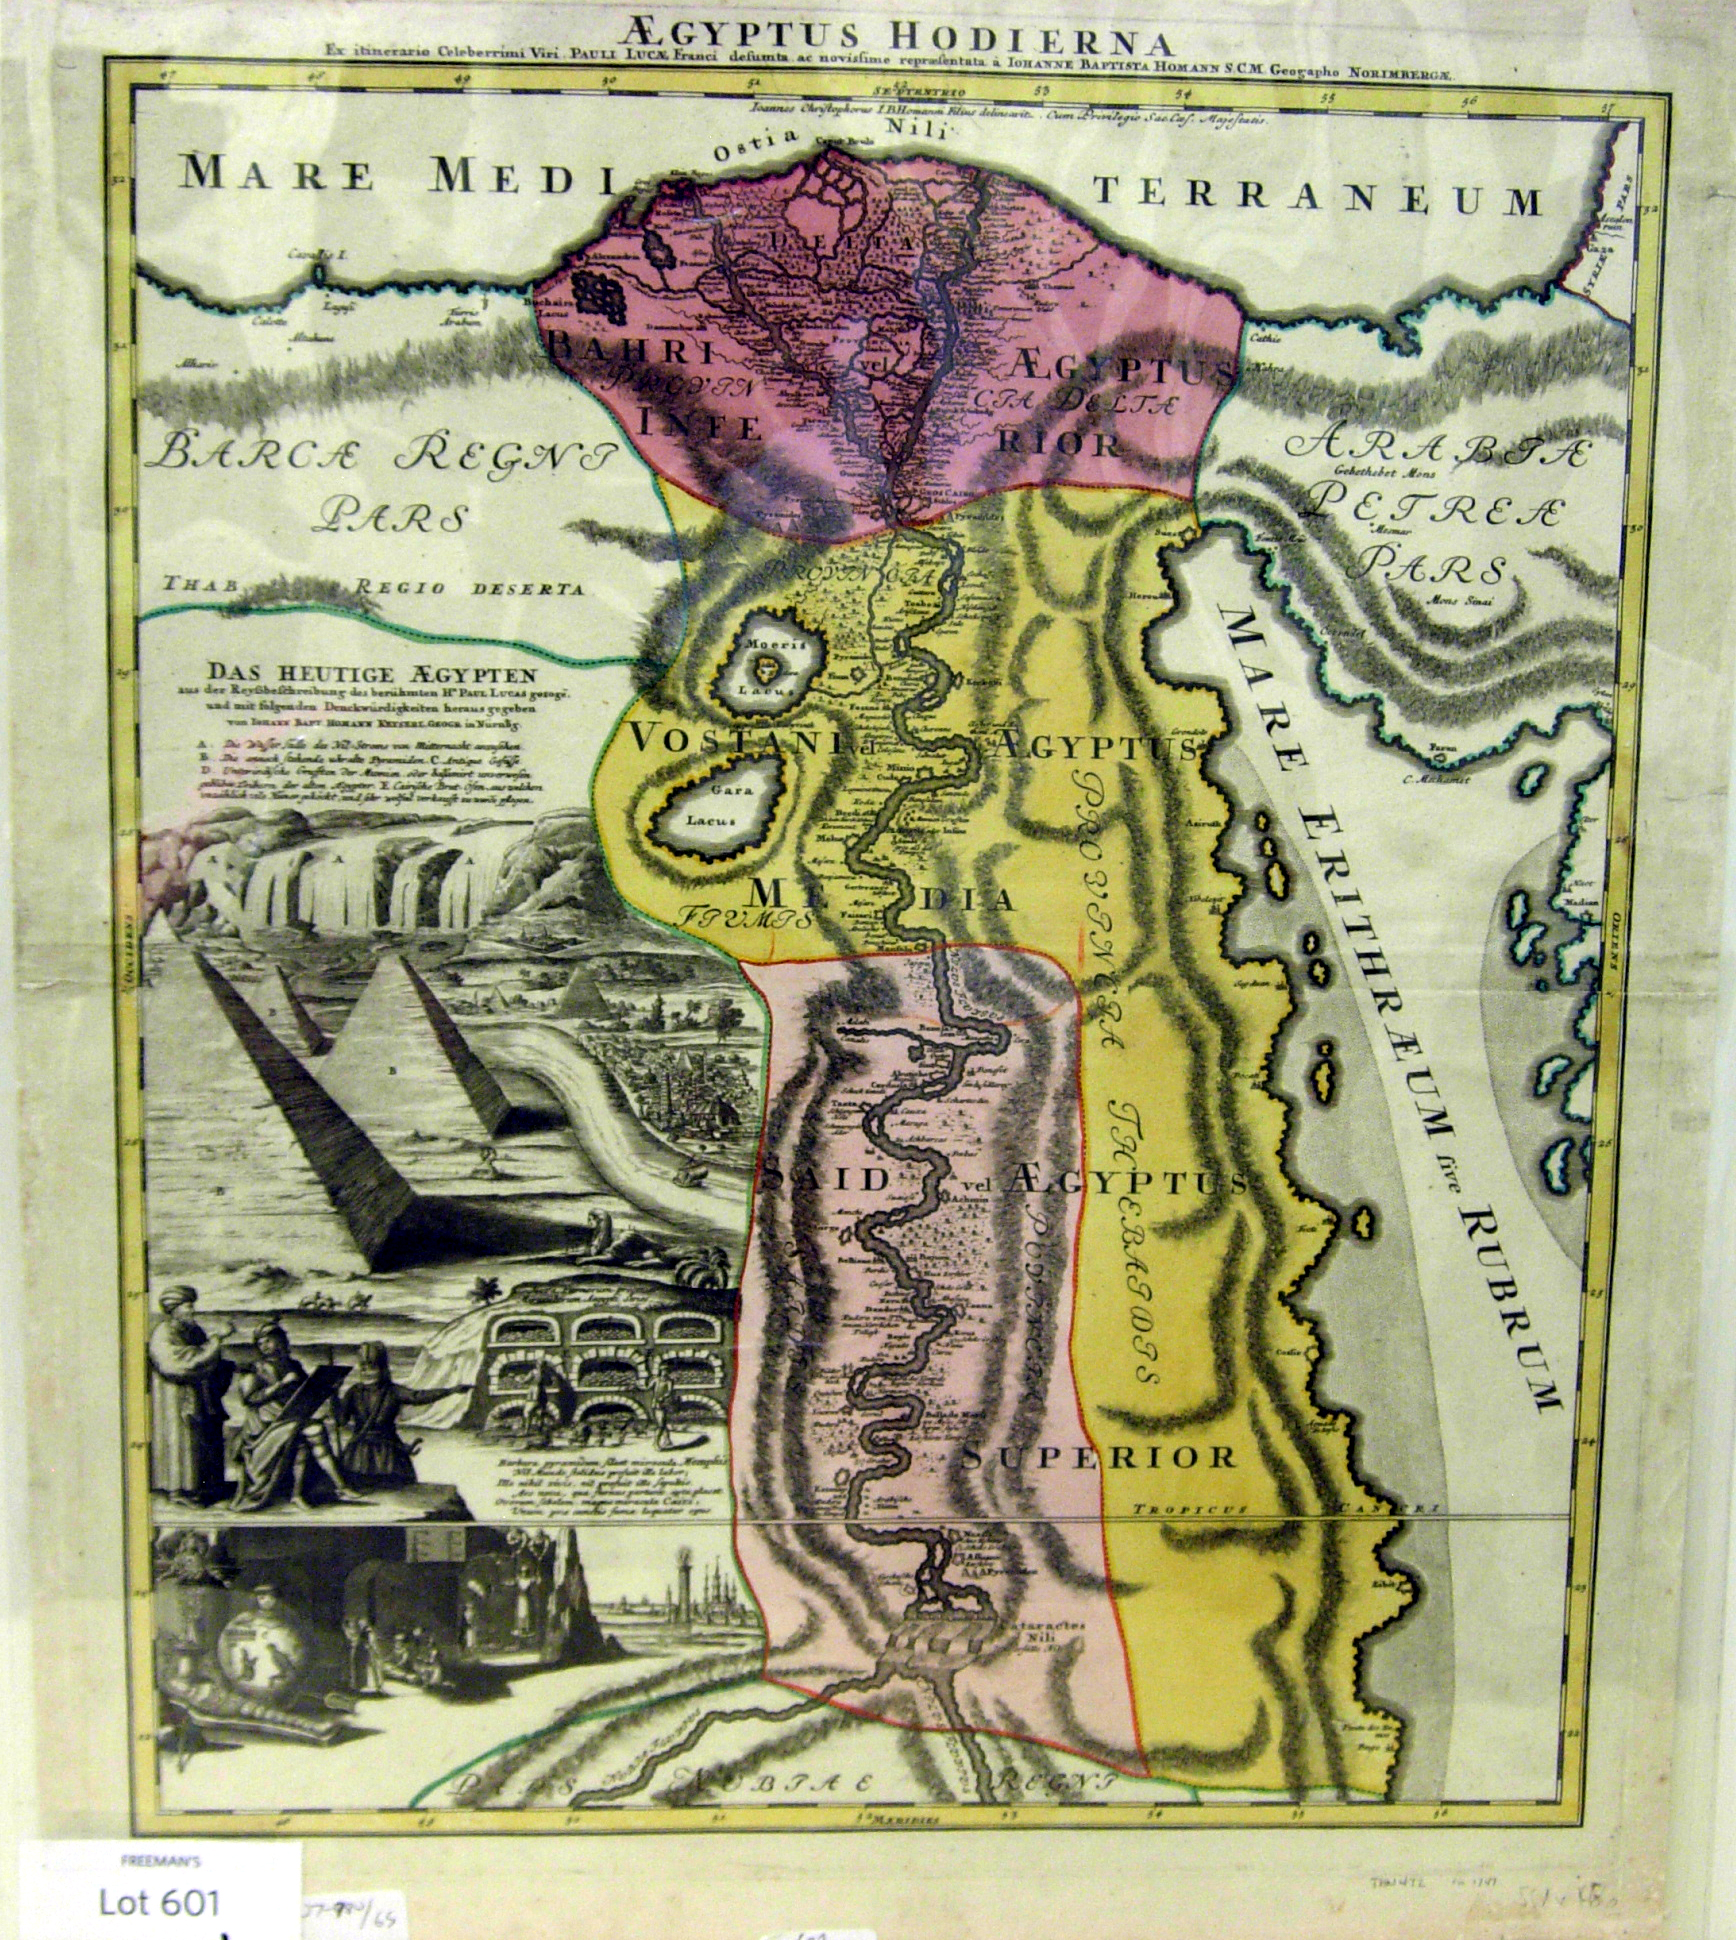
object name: map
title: Aegyptus Hodierna, Map of Egypt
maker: johann baptist homann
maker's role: artist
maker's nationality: german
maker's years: 1664-1724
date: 1720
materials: paper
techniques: engraving, etching, hand coloring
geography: germany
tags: maps